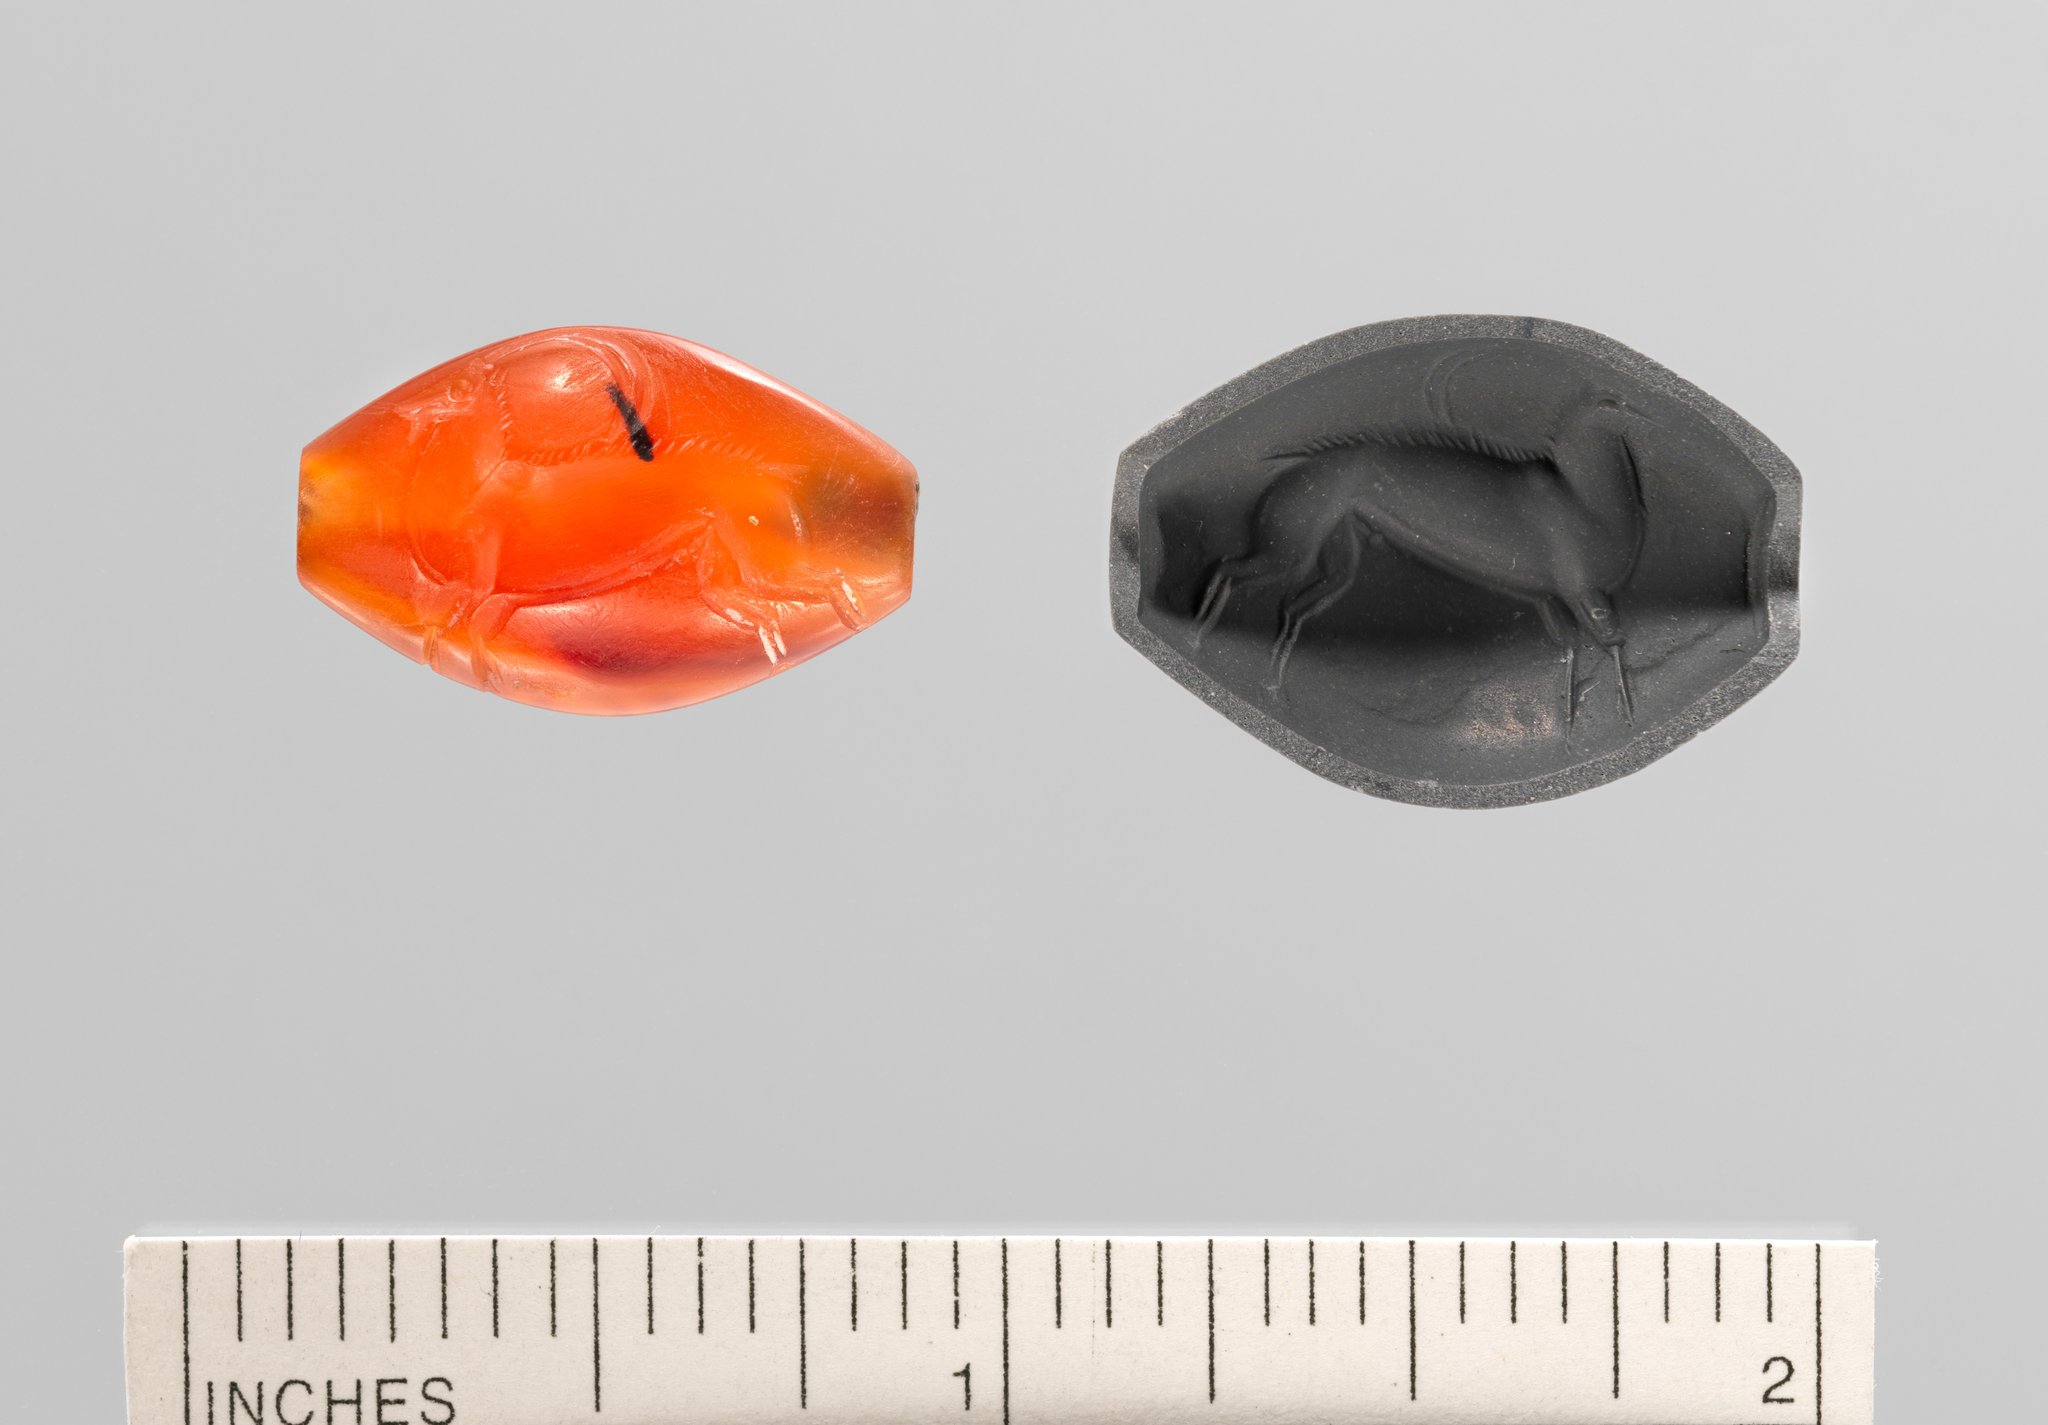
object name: seal, amygdaloid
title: Carnelian Amygdaloid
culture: minoan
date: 1500-1400 BCE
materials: gemstone